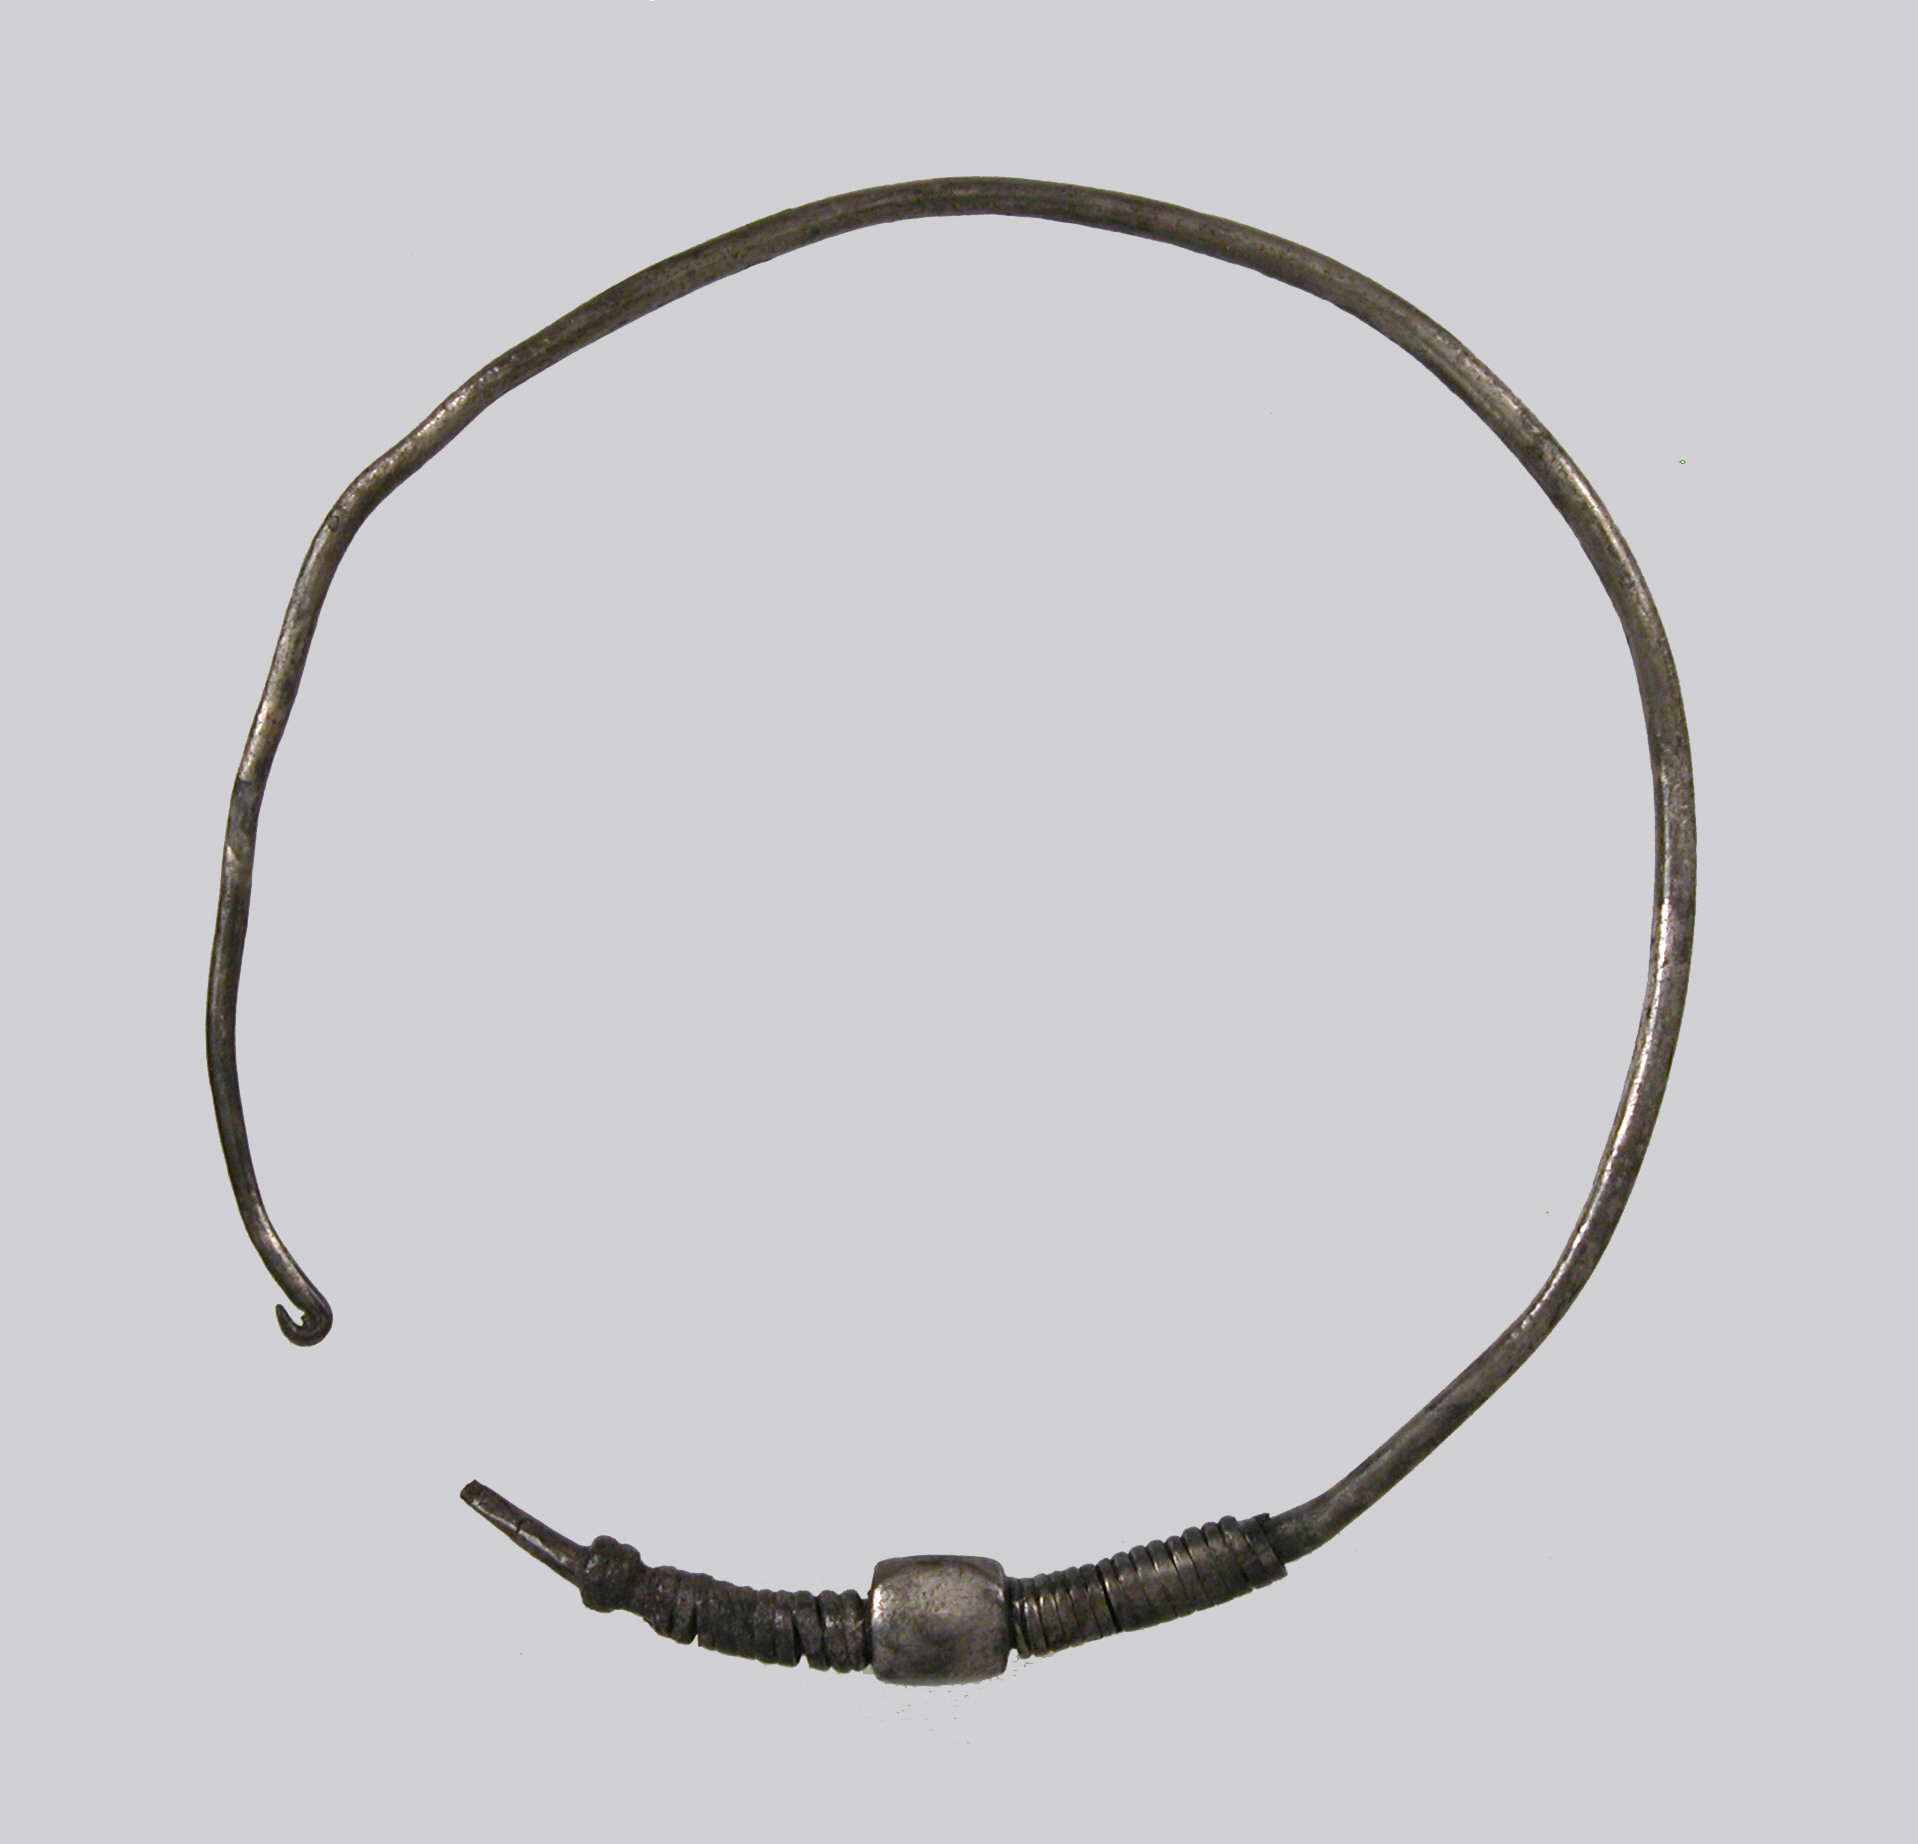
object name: earring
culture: frankish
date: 601-700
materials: silver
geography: germany